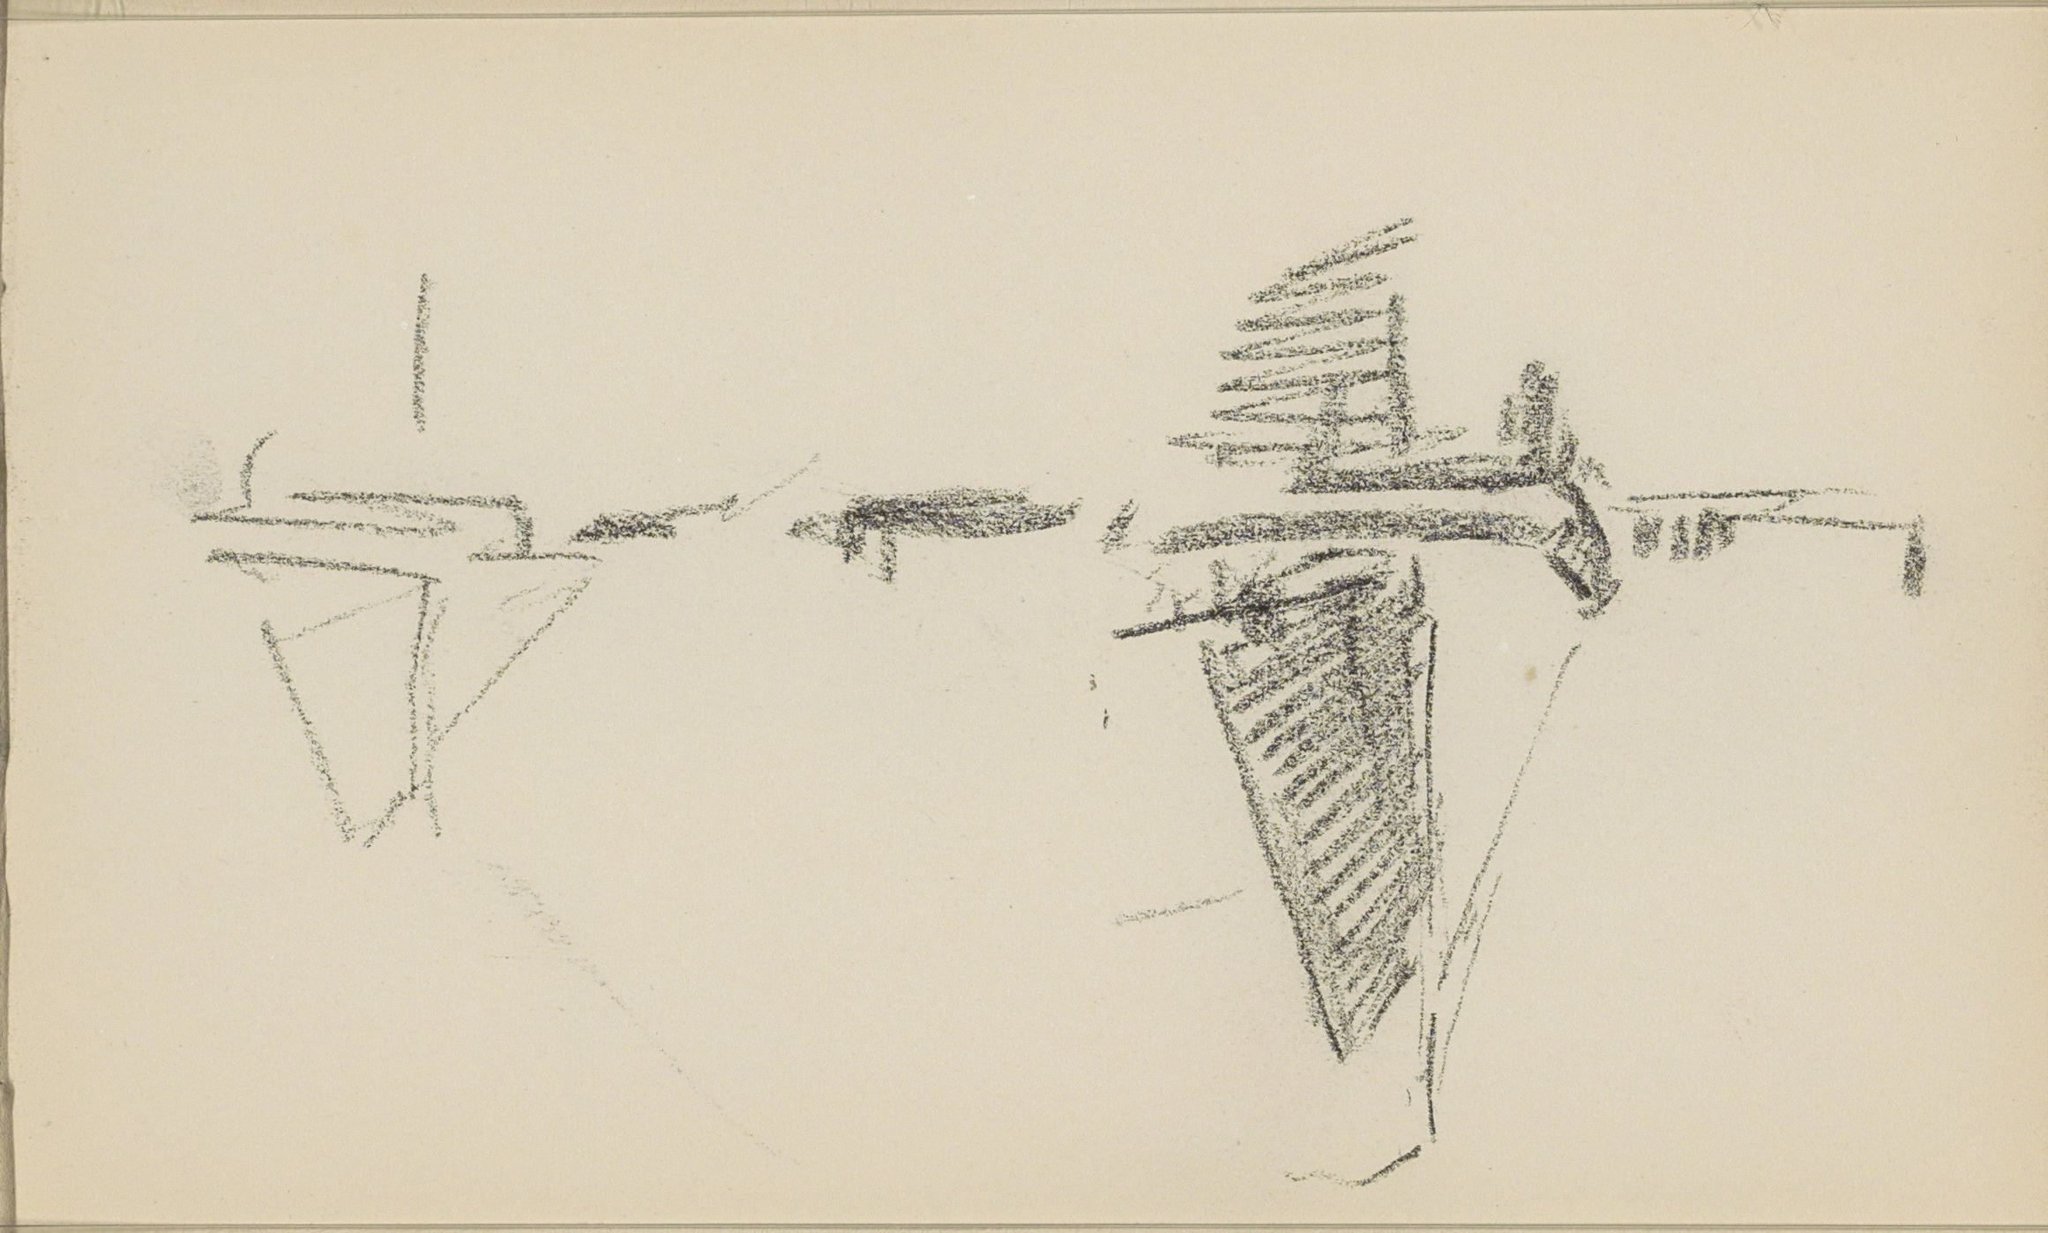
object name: sketchbook leaf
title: Twee zeilschepen op het water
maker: johan antonie de jonge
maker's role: draughtsman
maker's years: 1864-1927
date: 1901-1927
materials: chalk, paper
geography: south holland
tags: sailing-ship, sailing-boat, landscapes with waters, waterscapes, seascapes (in the temperate zone)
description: Twee zeilschepen in het water. Blad 35 recto uit een schetsboek met 45 bladen.